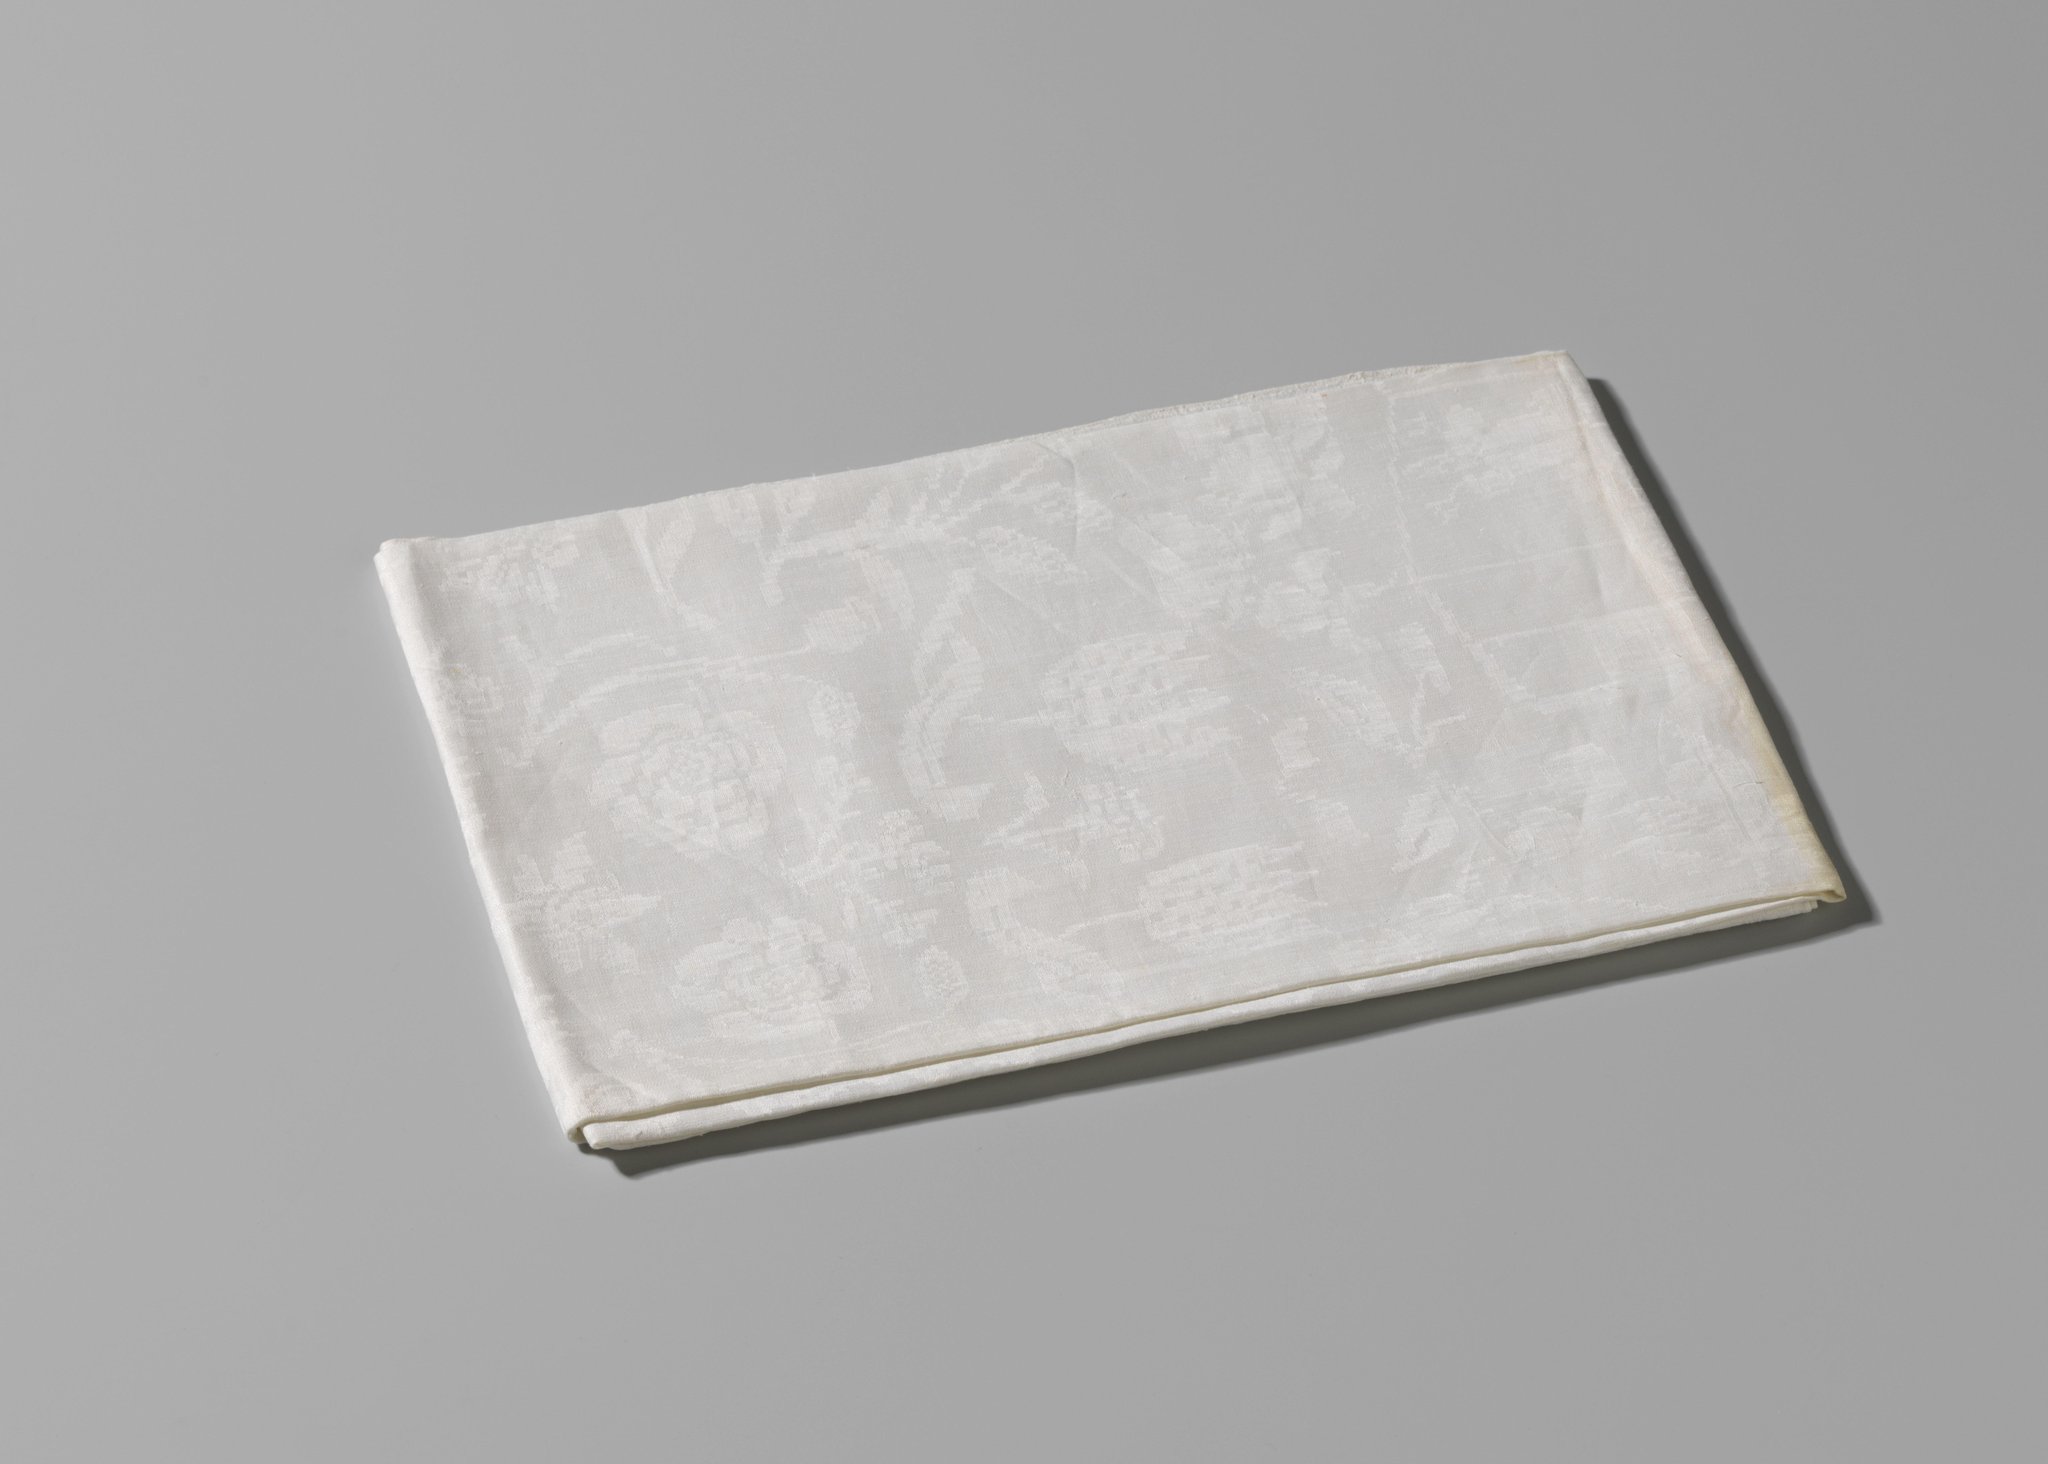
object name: woven material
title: Servet van wit linnendamast met gekoppelde wapens Von Inn- und Kniphausen en Van ewsum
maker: Anonymous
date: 1665-1670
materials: linen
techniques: damask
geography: northern netherlands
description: Servet van wit linnendamast met bloempatroon rondom de gekoppelde wapens Von Inn- und Kniphausen en Van Ewsum. Gemerkt: kroon LE 17.